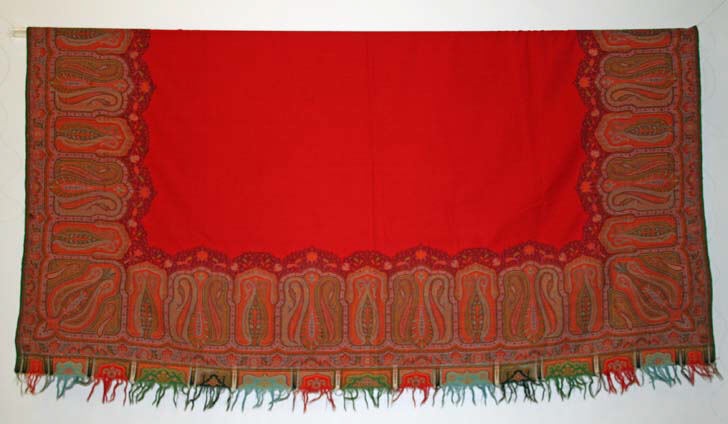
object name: shawl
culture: british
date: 1834-1866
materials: wool